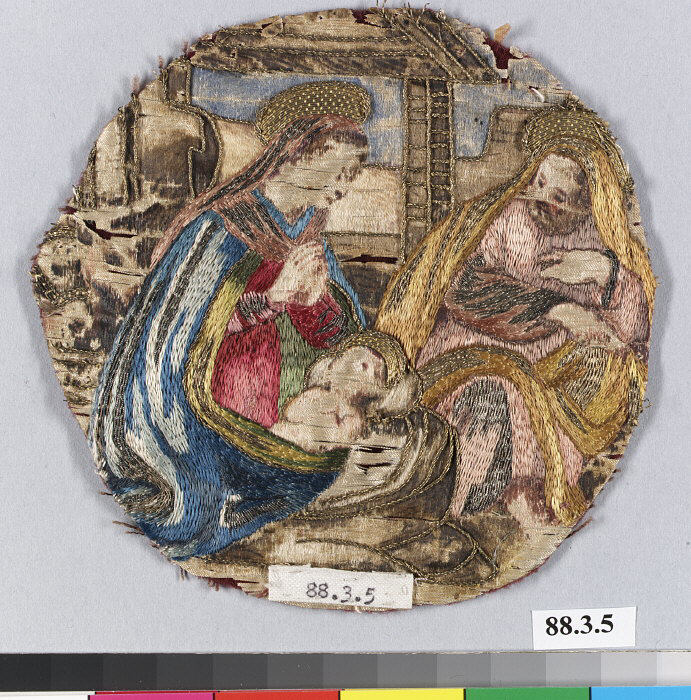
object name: panel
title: The Holy Family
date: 1501-1600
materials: metal thread, silk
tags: holy family,madonna and child